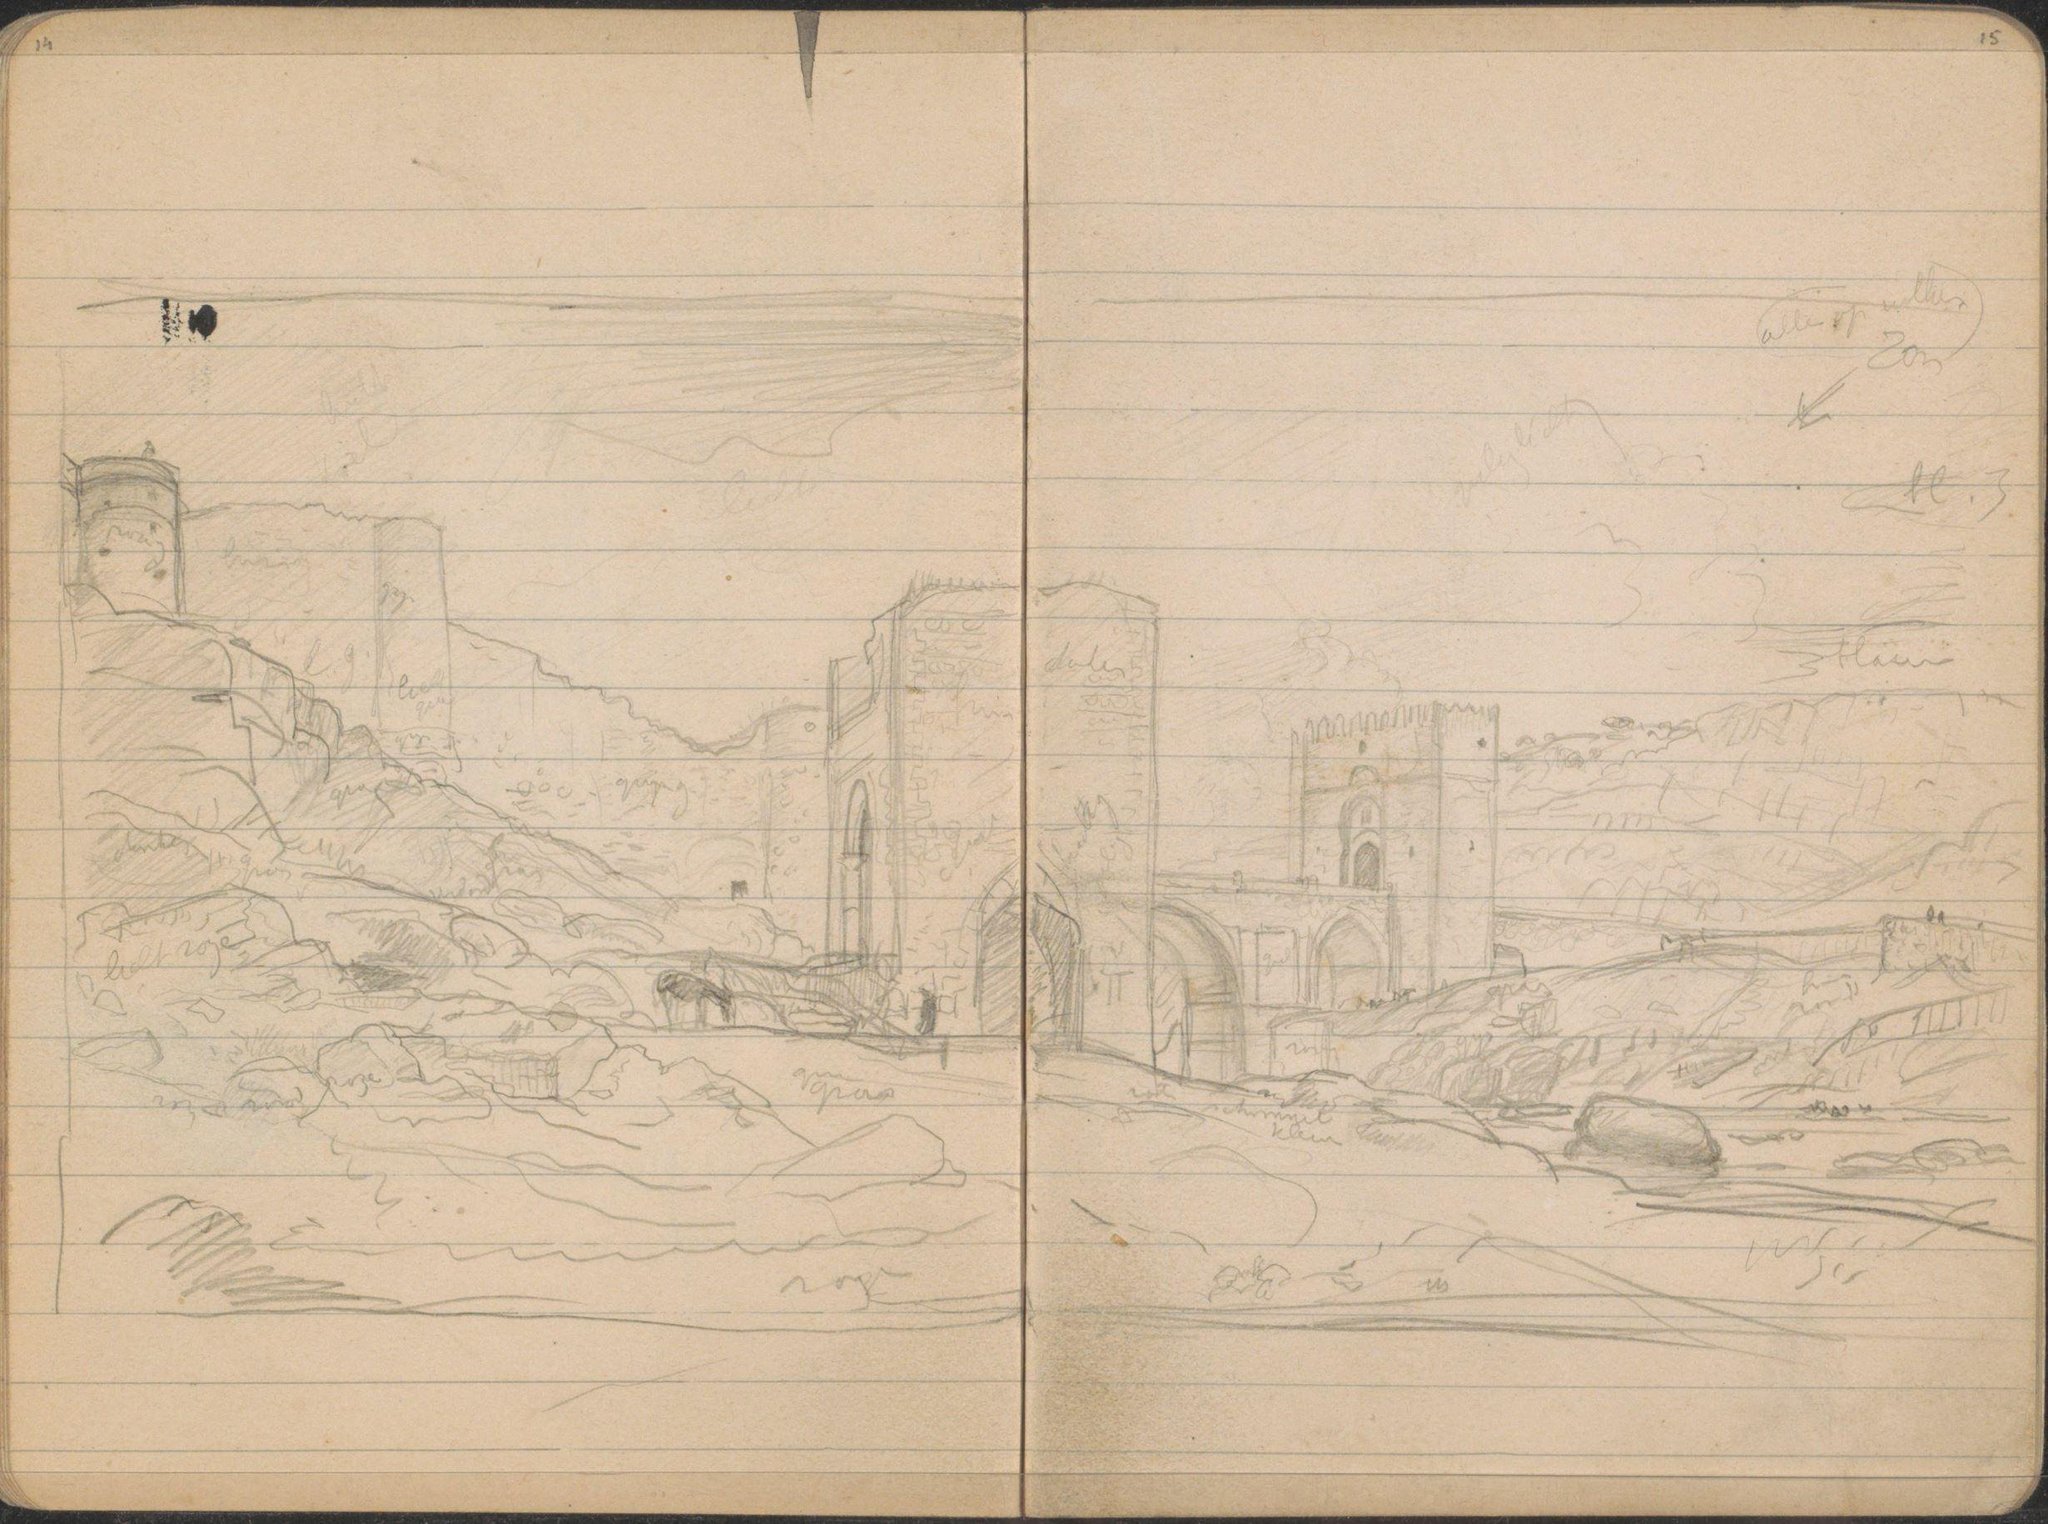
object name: sketchbook leaf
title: Landschap met de Alcántara brug over de Taag in Toledo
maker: marius bauer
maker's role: draughtsman, print maker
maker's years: 1867-1932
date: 1902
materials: pencil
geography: toledo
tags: city-view, and landscape with man-made constructions, bridge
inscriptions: kleurnotitie, handgeschreven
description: Pagina 14 en 15 uit een schetsboek met 50 bladen.